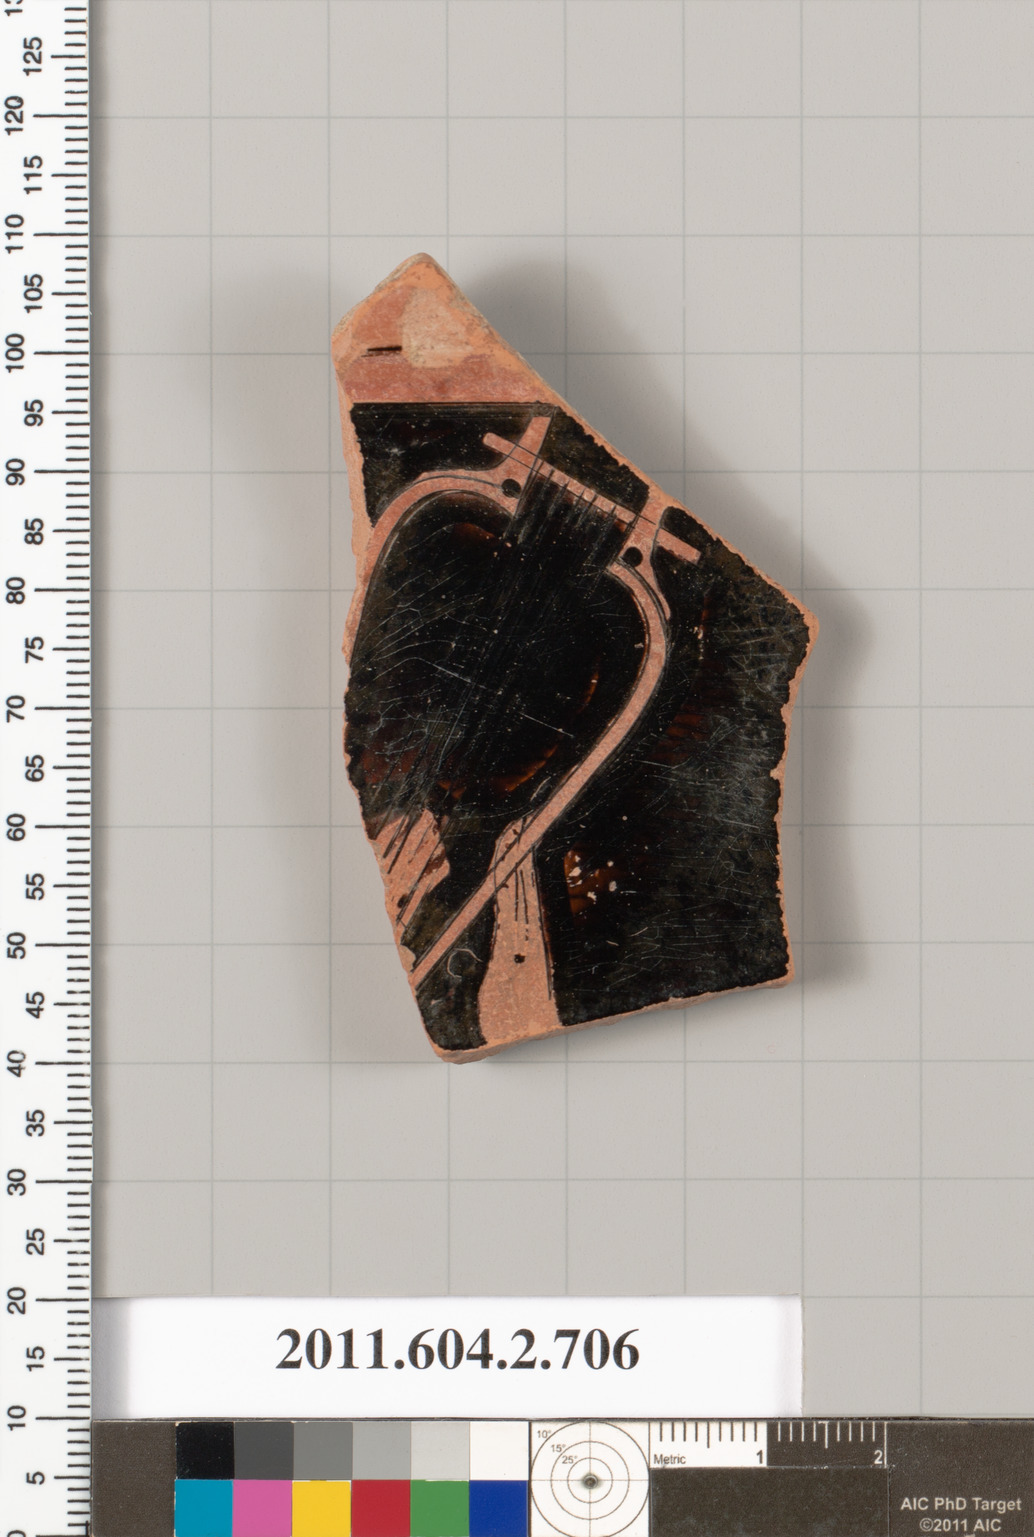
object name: calyx krater fragment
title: Terracotta fragment of a calyx-krater (bowl for mixing wine and water)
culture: greek, attic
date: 470-460 BCE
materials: terracotta